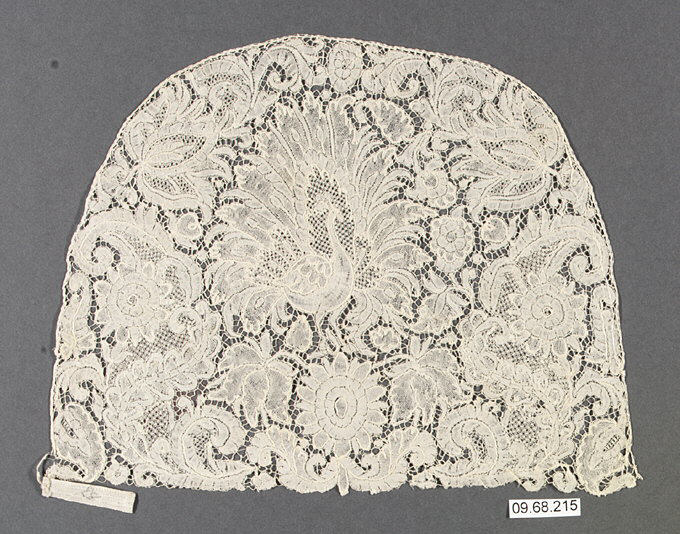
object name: cap crown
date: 1701-1733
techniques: lace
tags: peacocks,flowers,leaves